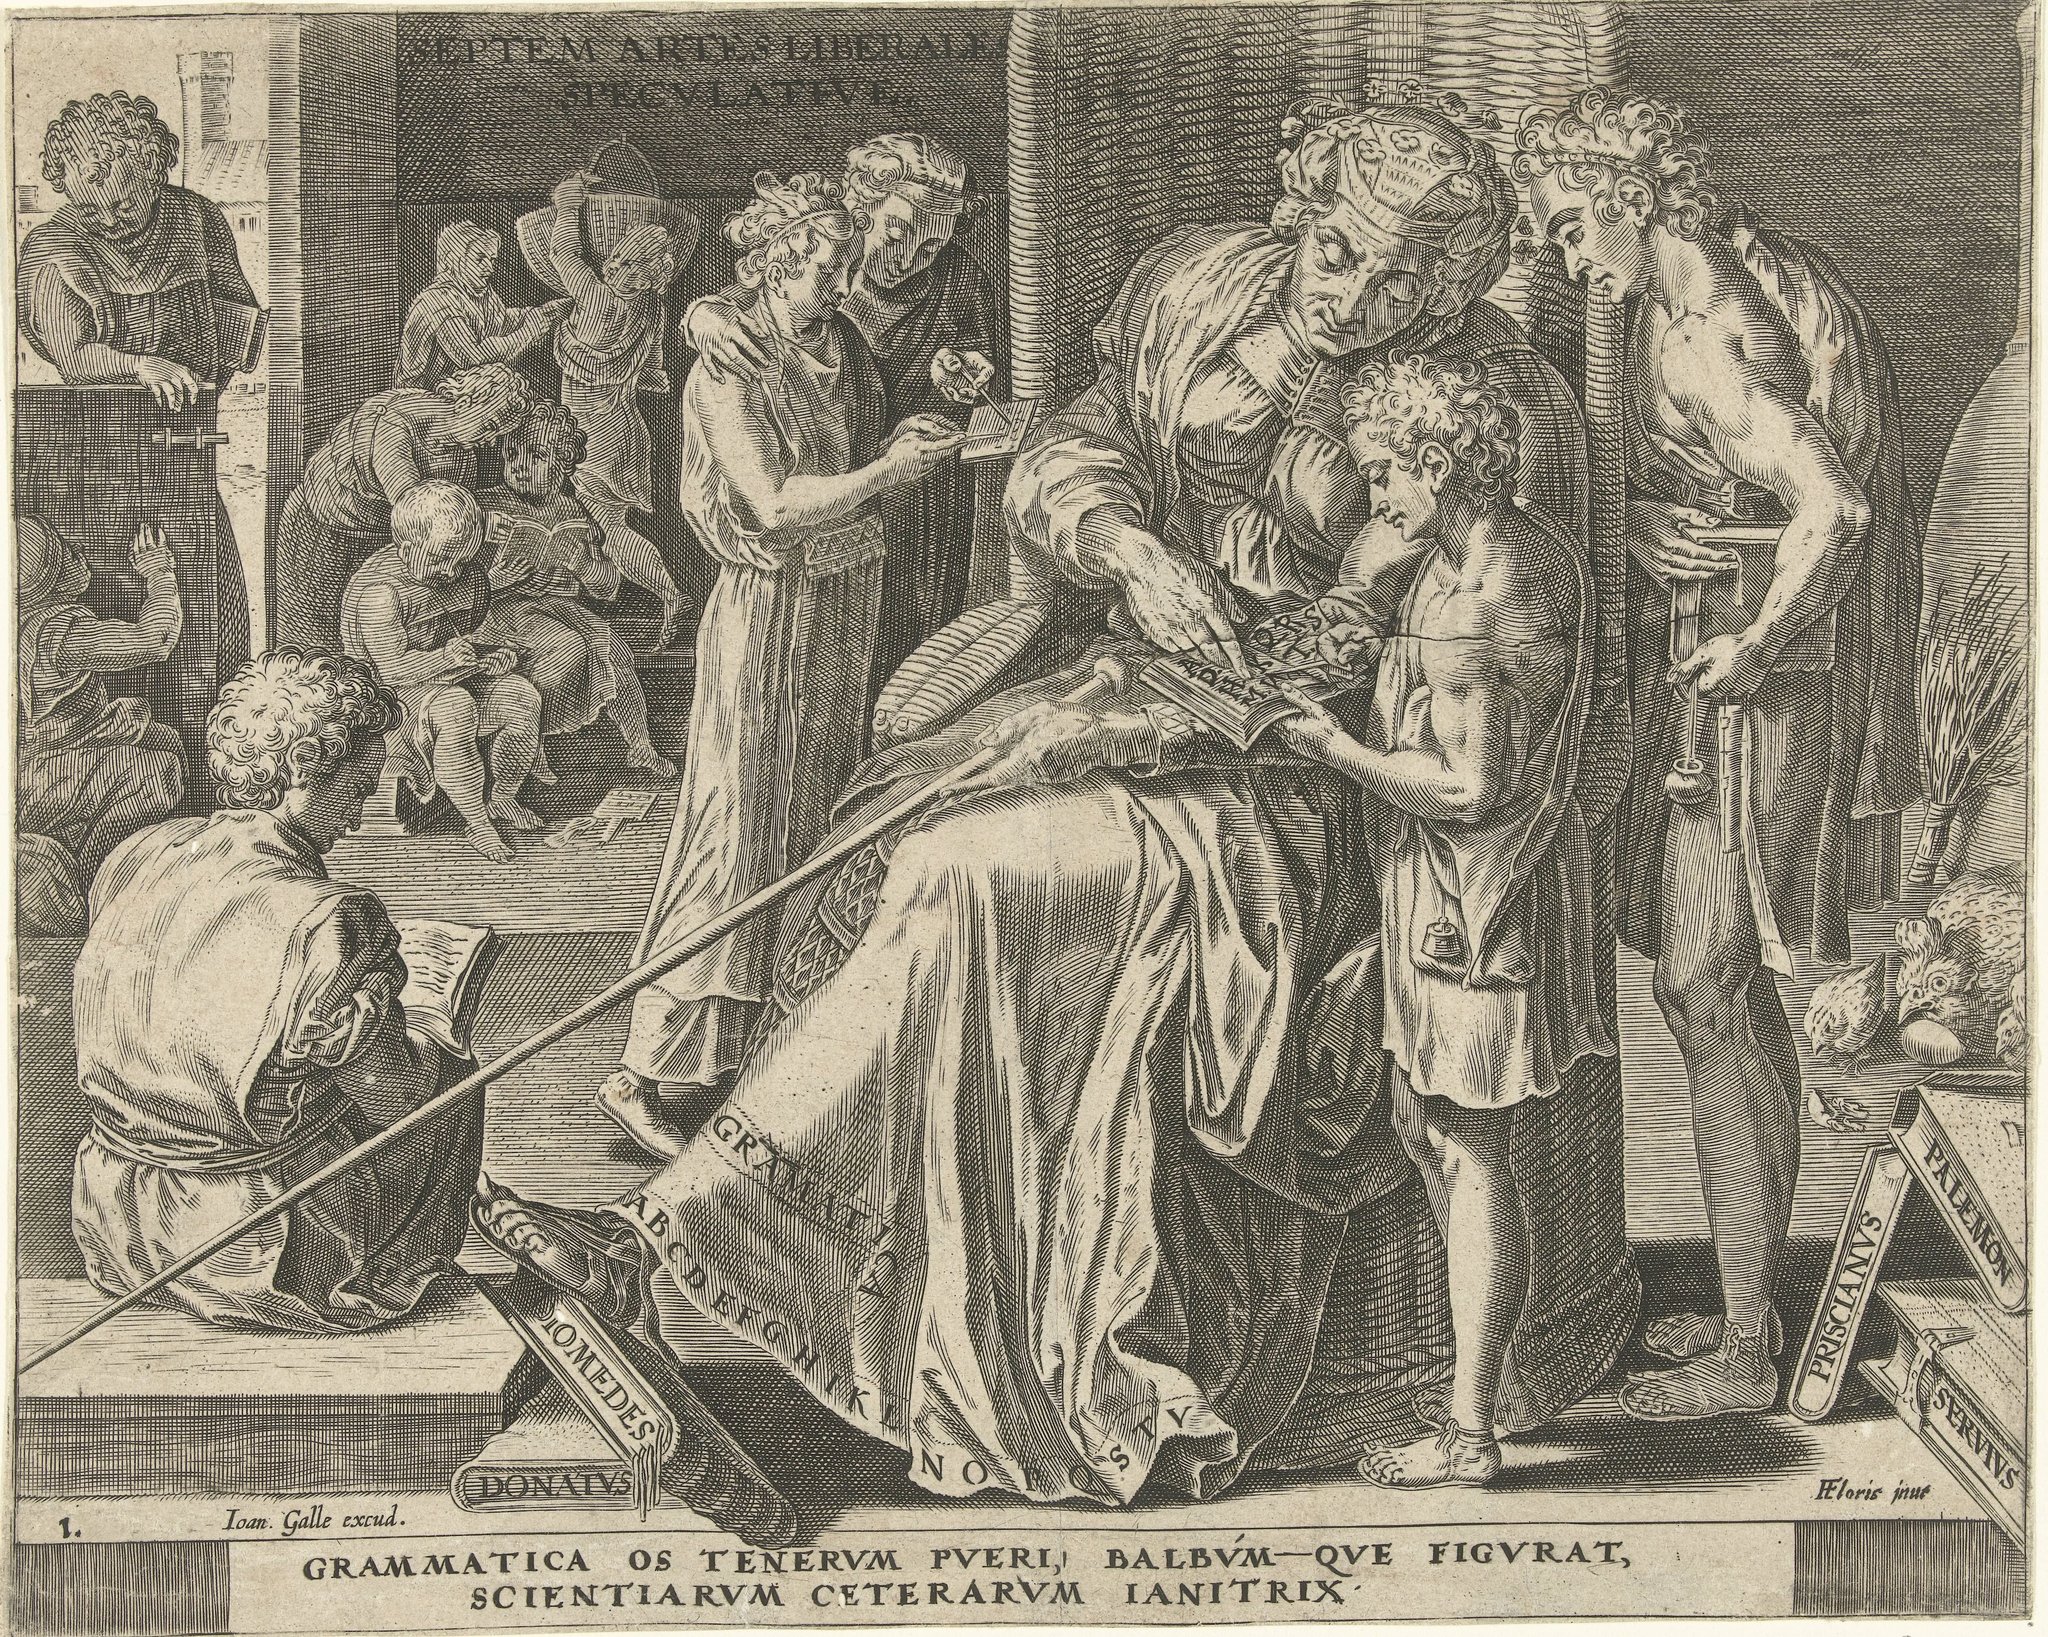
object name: print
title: De zeven vrije kunsten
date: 1633-1676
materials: paper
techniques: engraving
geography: antwerp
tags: 'grammatica' (~ trivium); 'grammatica' (ripa) (+ professional clothes of scholar, scientist)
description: Grammatica zit als oudere lerares te midden van haar leerlingen. In de klas zitten leerlingen van verschillende leeftijden. Achter leren de jongste kinderen schrijven. Links voor leest een ouder kind in een boek. Grammatica helpt een andere leerling die met een boek naast haar staat. In haar schoot ligt een wijsstok. Op de grond liggen boeken van beroemde schrijvers op het gebied van de spraakkunst zoals Donatus en Diomedes.